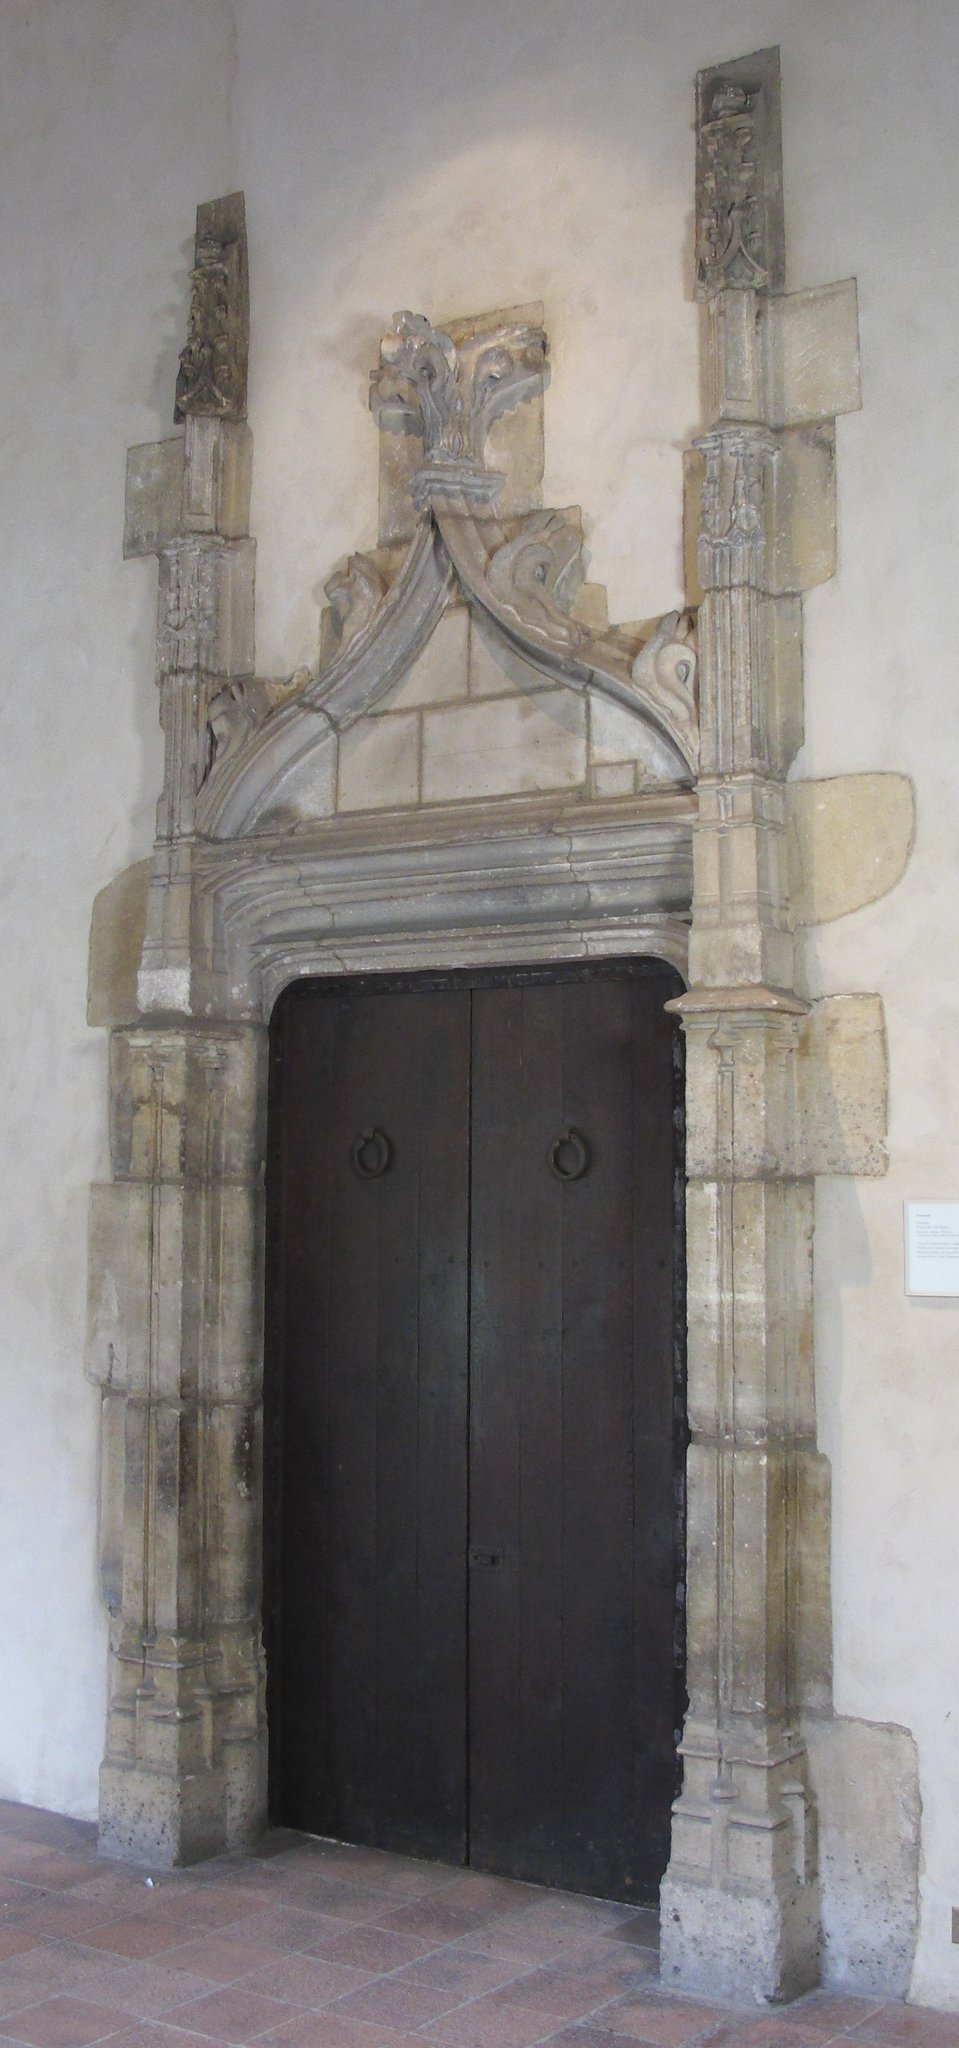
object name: doorway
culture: french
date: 1467-1500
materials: limestone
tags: doorways